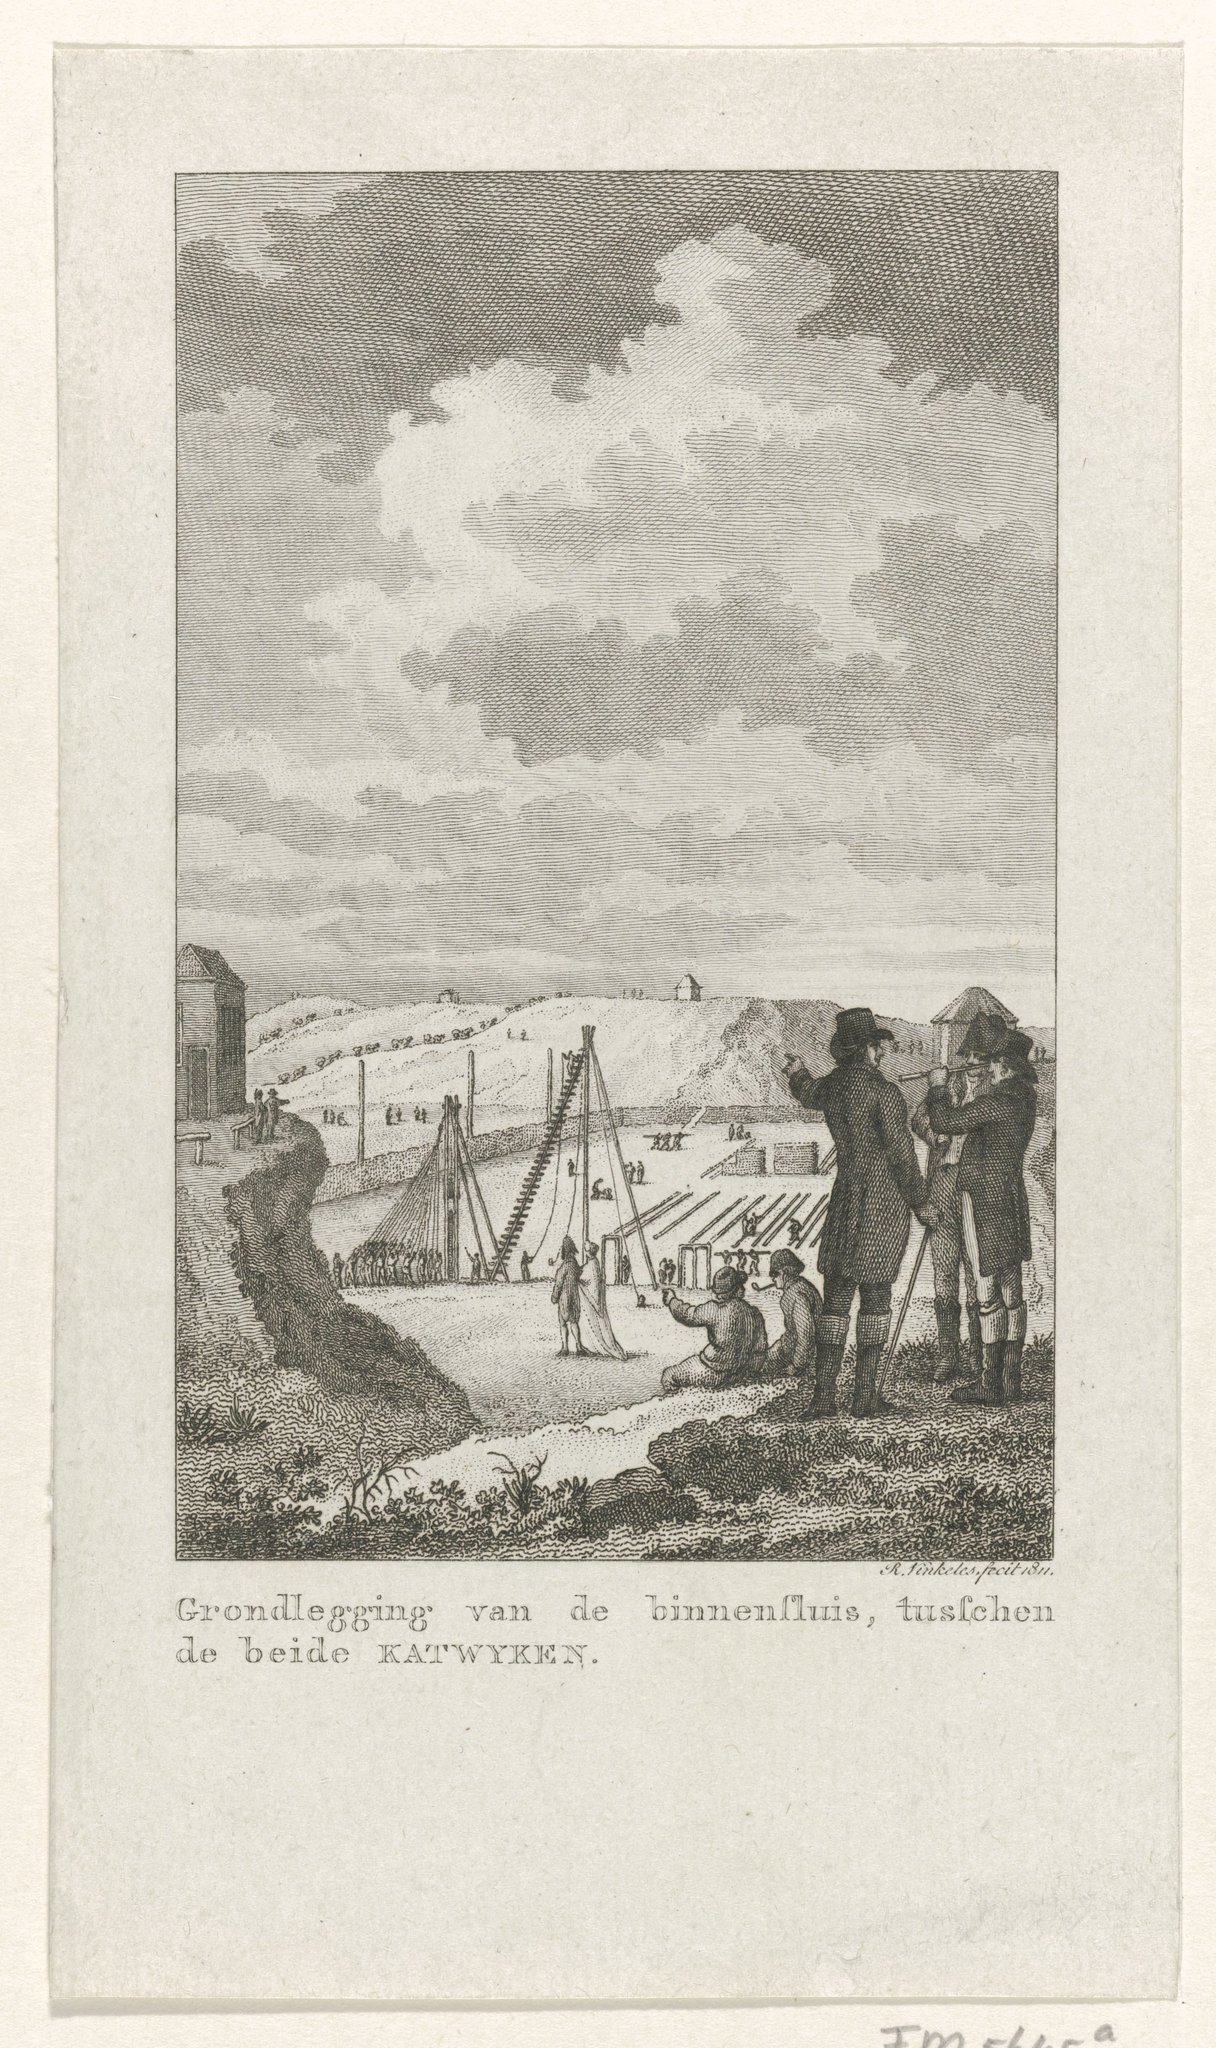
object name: history print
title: Grondlegging van de binnensluis, tusschen de beide Katwyken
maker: reinier vinkeles (i)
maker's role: draughtsman, print maker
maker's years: 1741-1816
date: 1811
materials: paper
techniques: engraving, etching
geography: netherlands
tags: construction of canal, ramming, driving piles (~ building activities)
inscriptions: collector's mark: Lugt 2228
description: De aanleg van het Katwijks Kanaal (een binnensluis) tussen Katwijk aan Zee en Katwijk aan den Rijn, 1805. Gezicht op de heiwerkzaamheden in de duinen. Op de voorgrond volgen enkele bouwopzichters of ingenieurs het werk met een verrekijker.